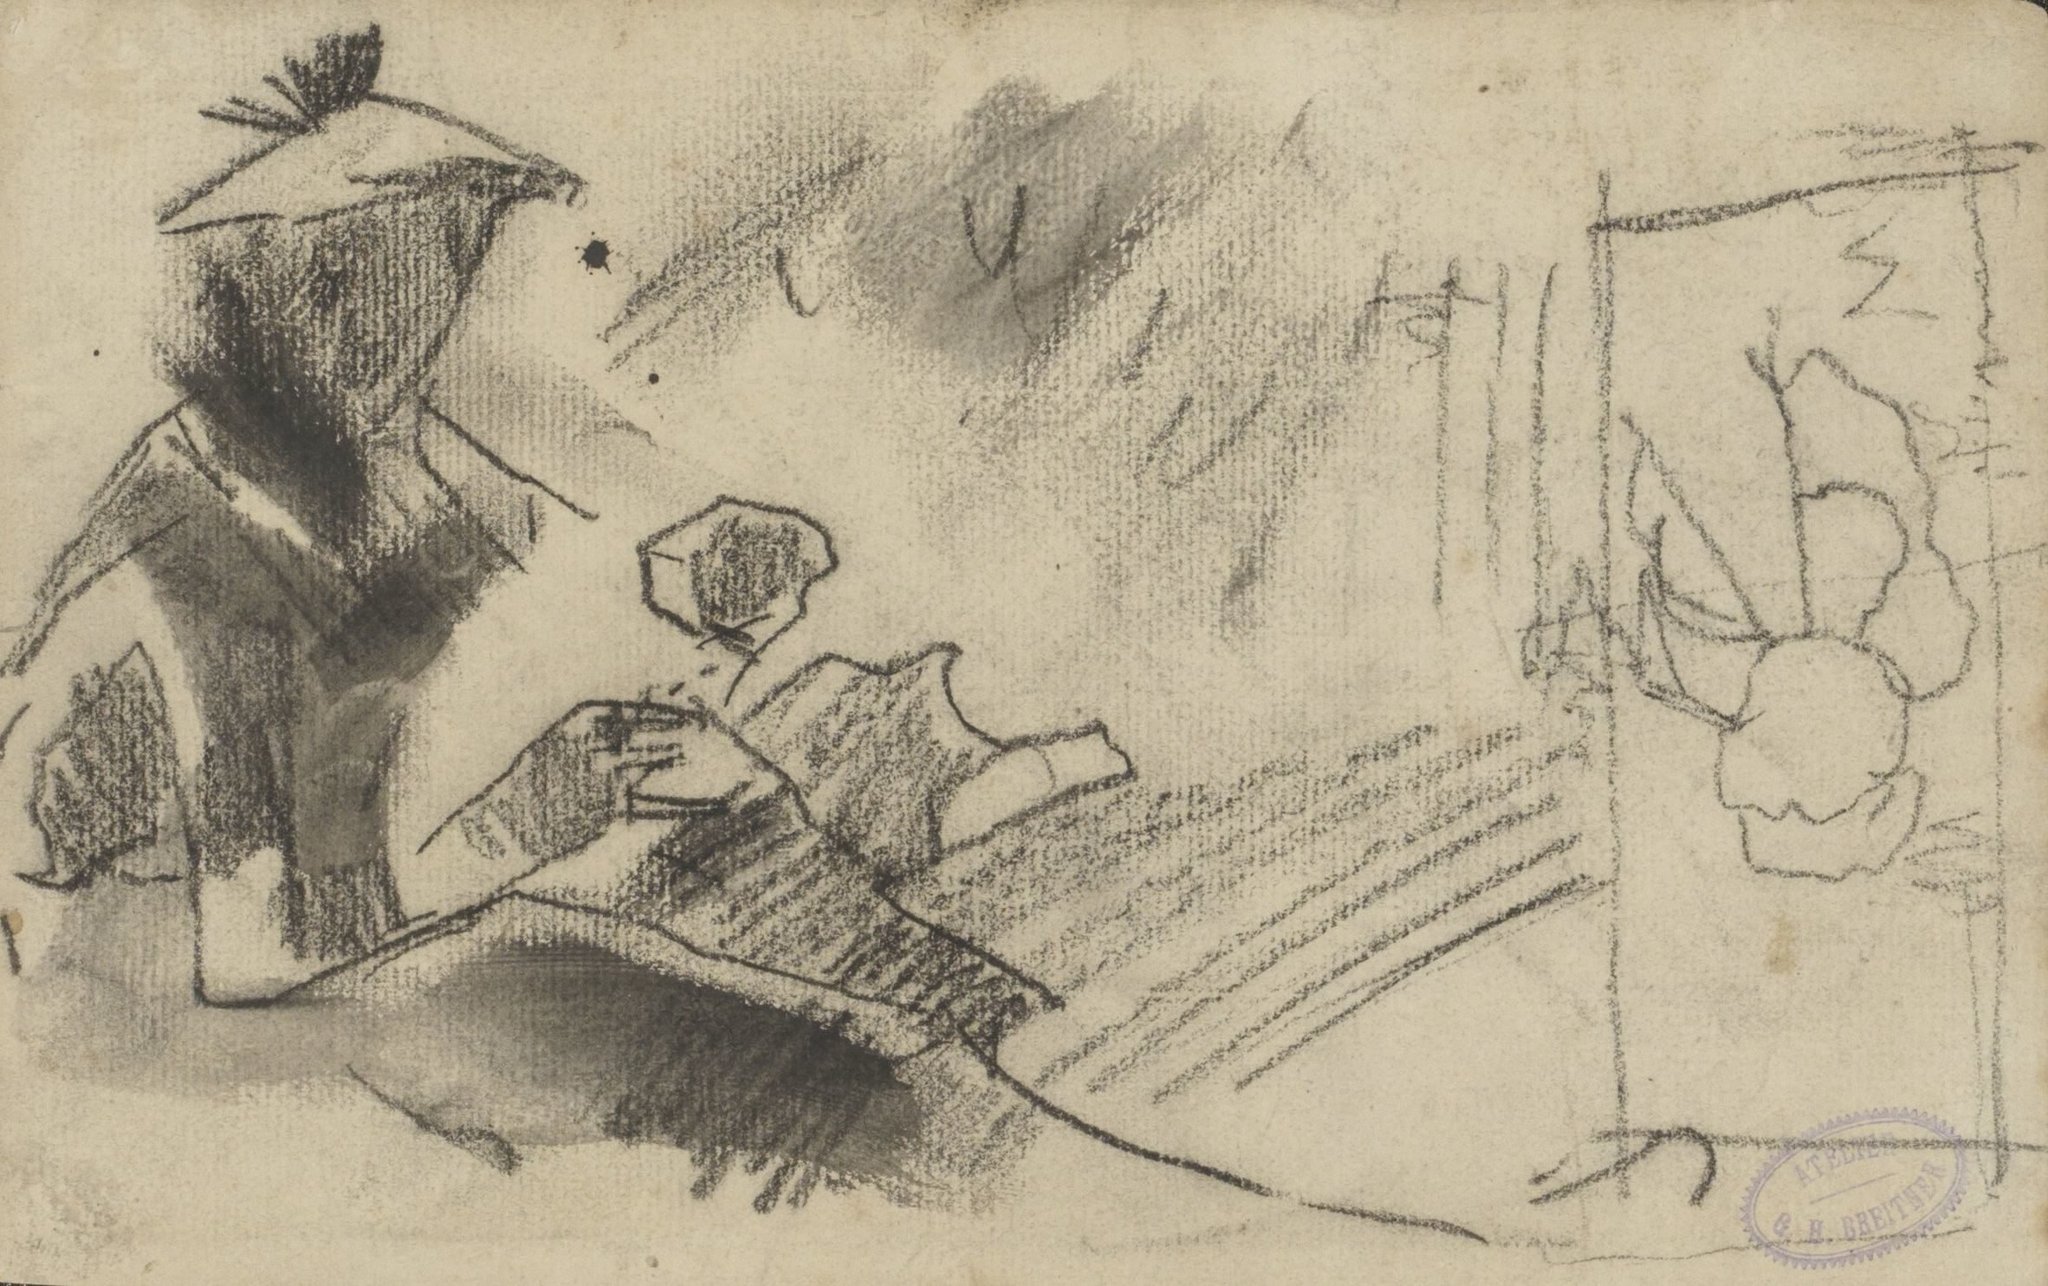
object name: drawing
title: Zittende vrouw met hoed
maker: george hendrik breitner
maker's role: draughtsman, painter, print maker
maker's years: 1857-1923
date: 1895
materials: chalk, paper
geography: the hague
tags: sitting figure - aa - female human figure, head-gear: hat (+ women's clothes)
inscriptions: workshop stamp: Lugt 291d